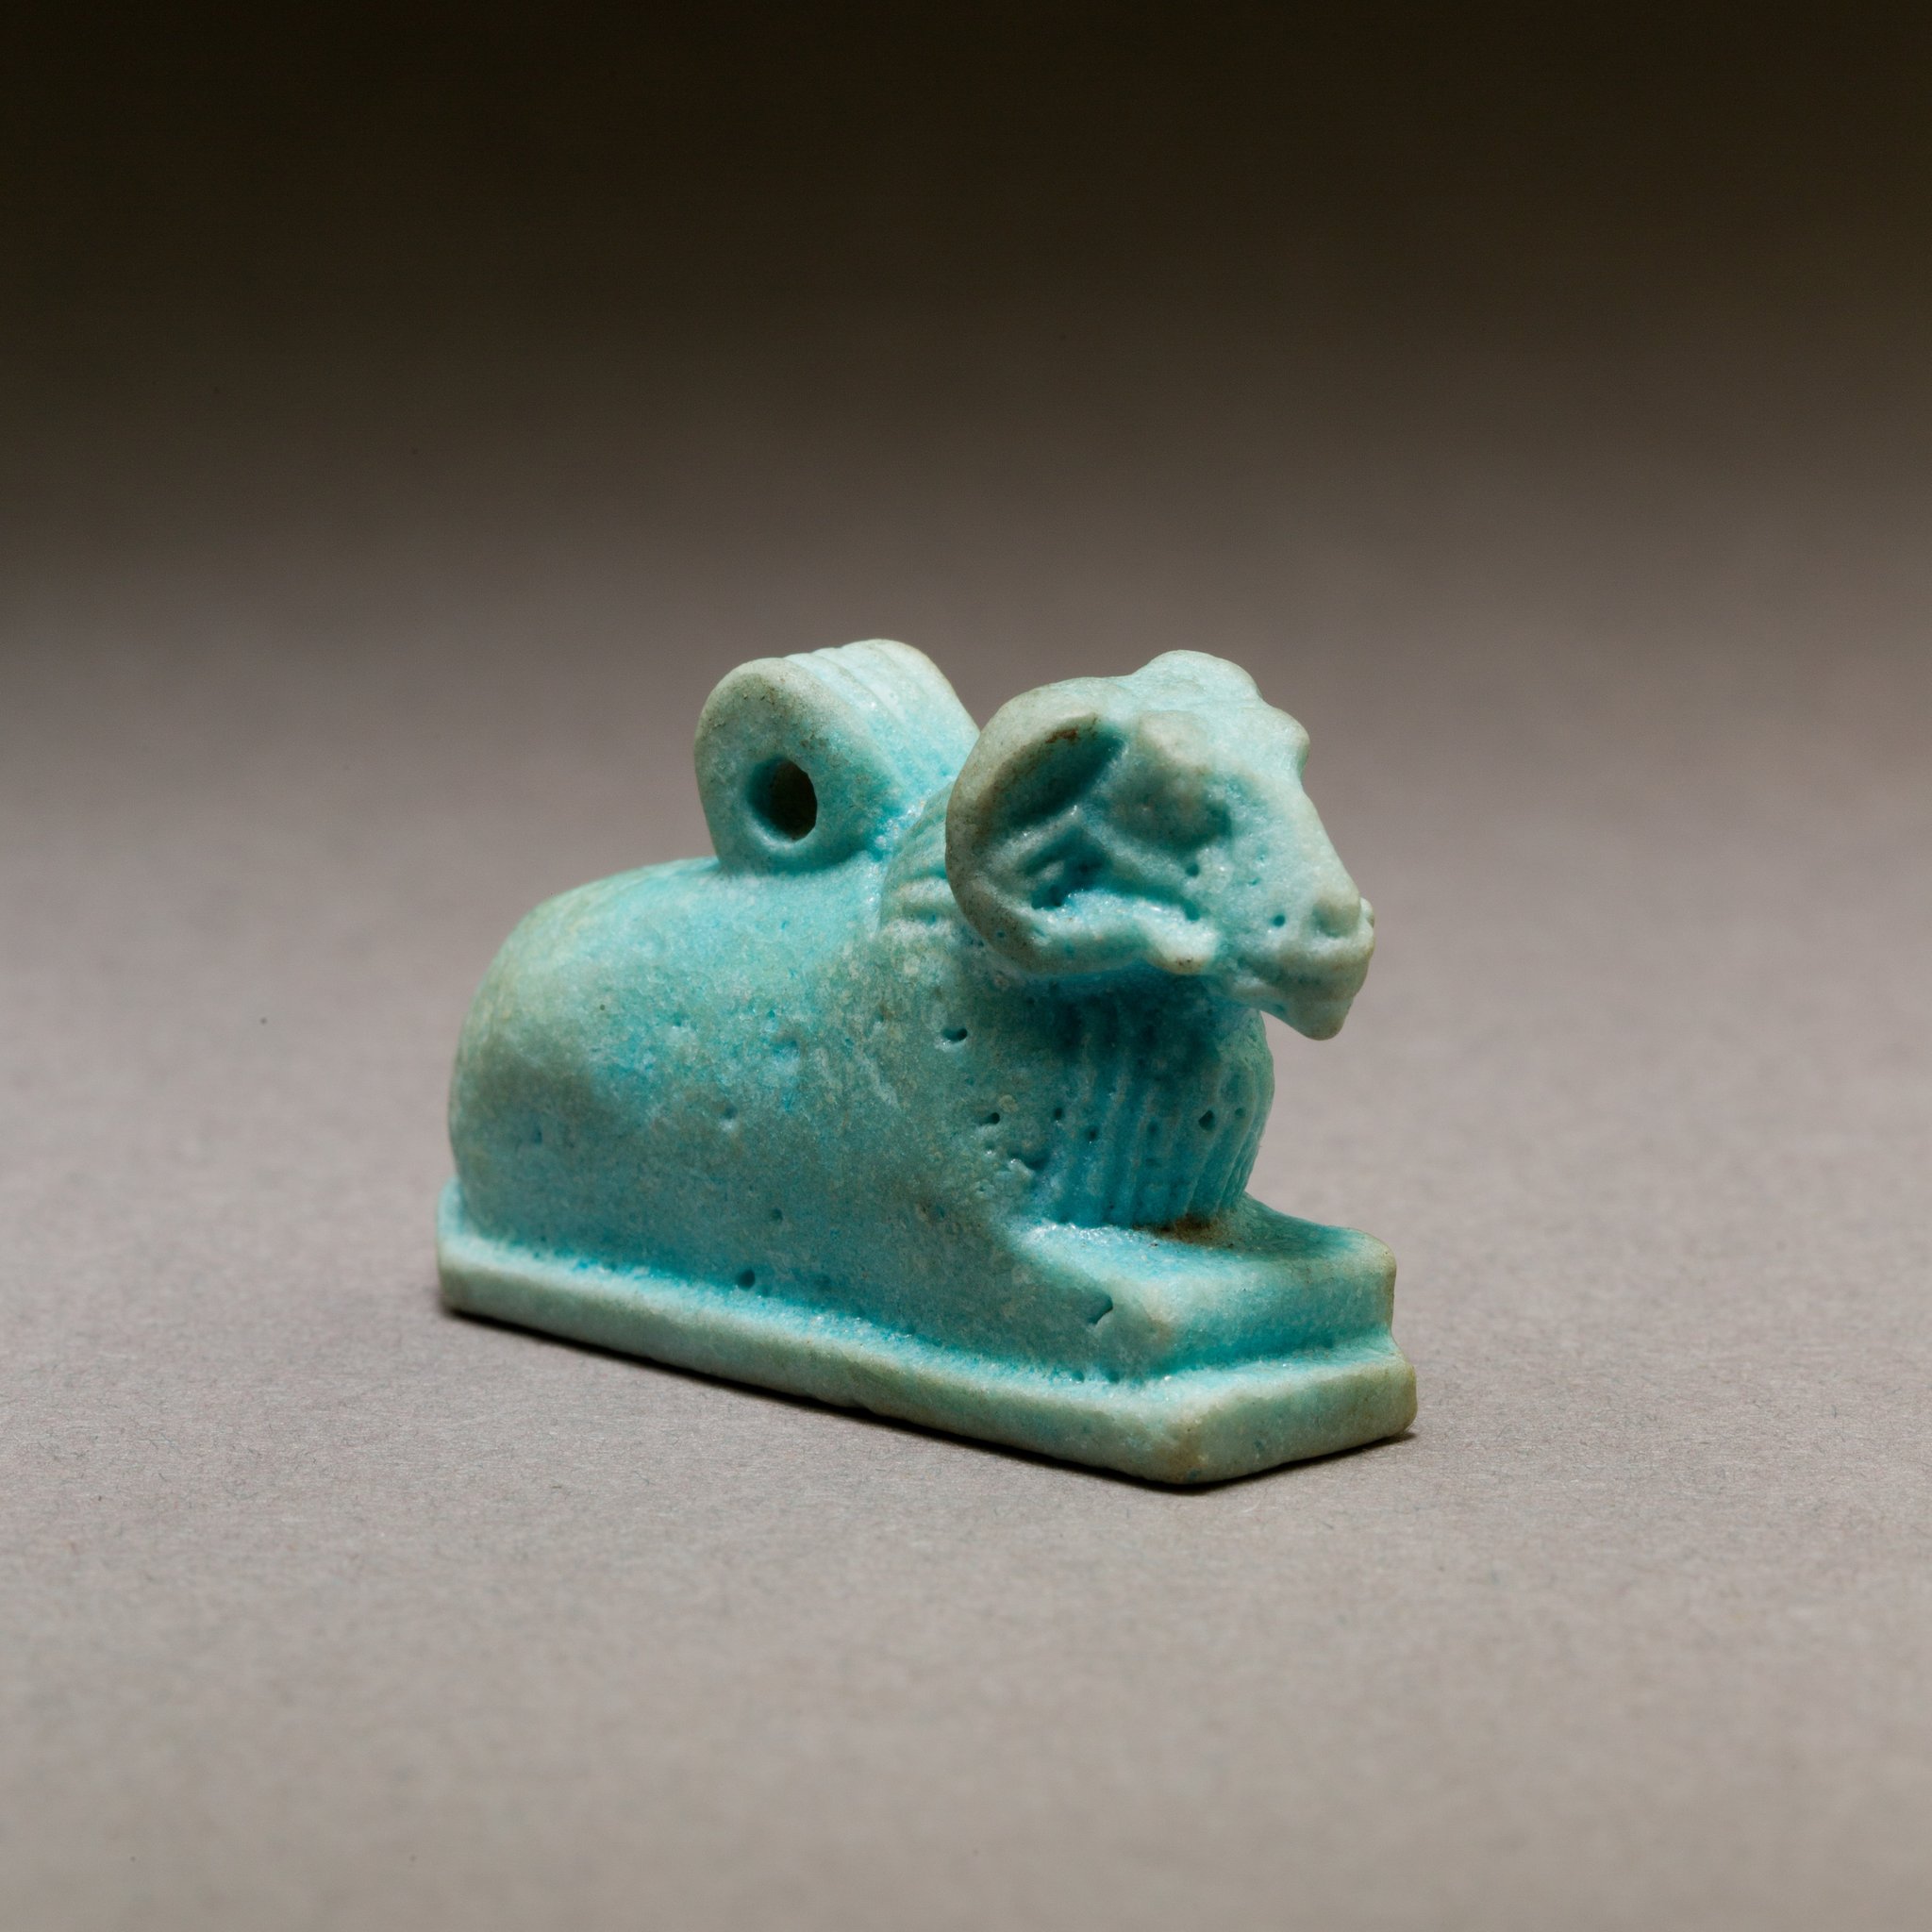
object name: amulet, ram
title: Ram amulet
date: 664-630 BCE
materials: faience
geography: egypt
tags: rams